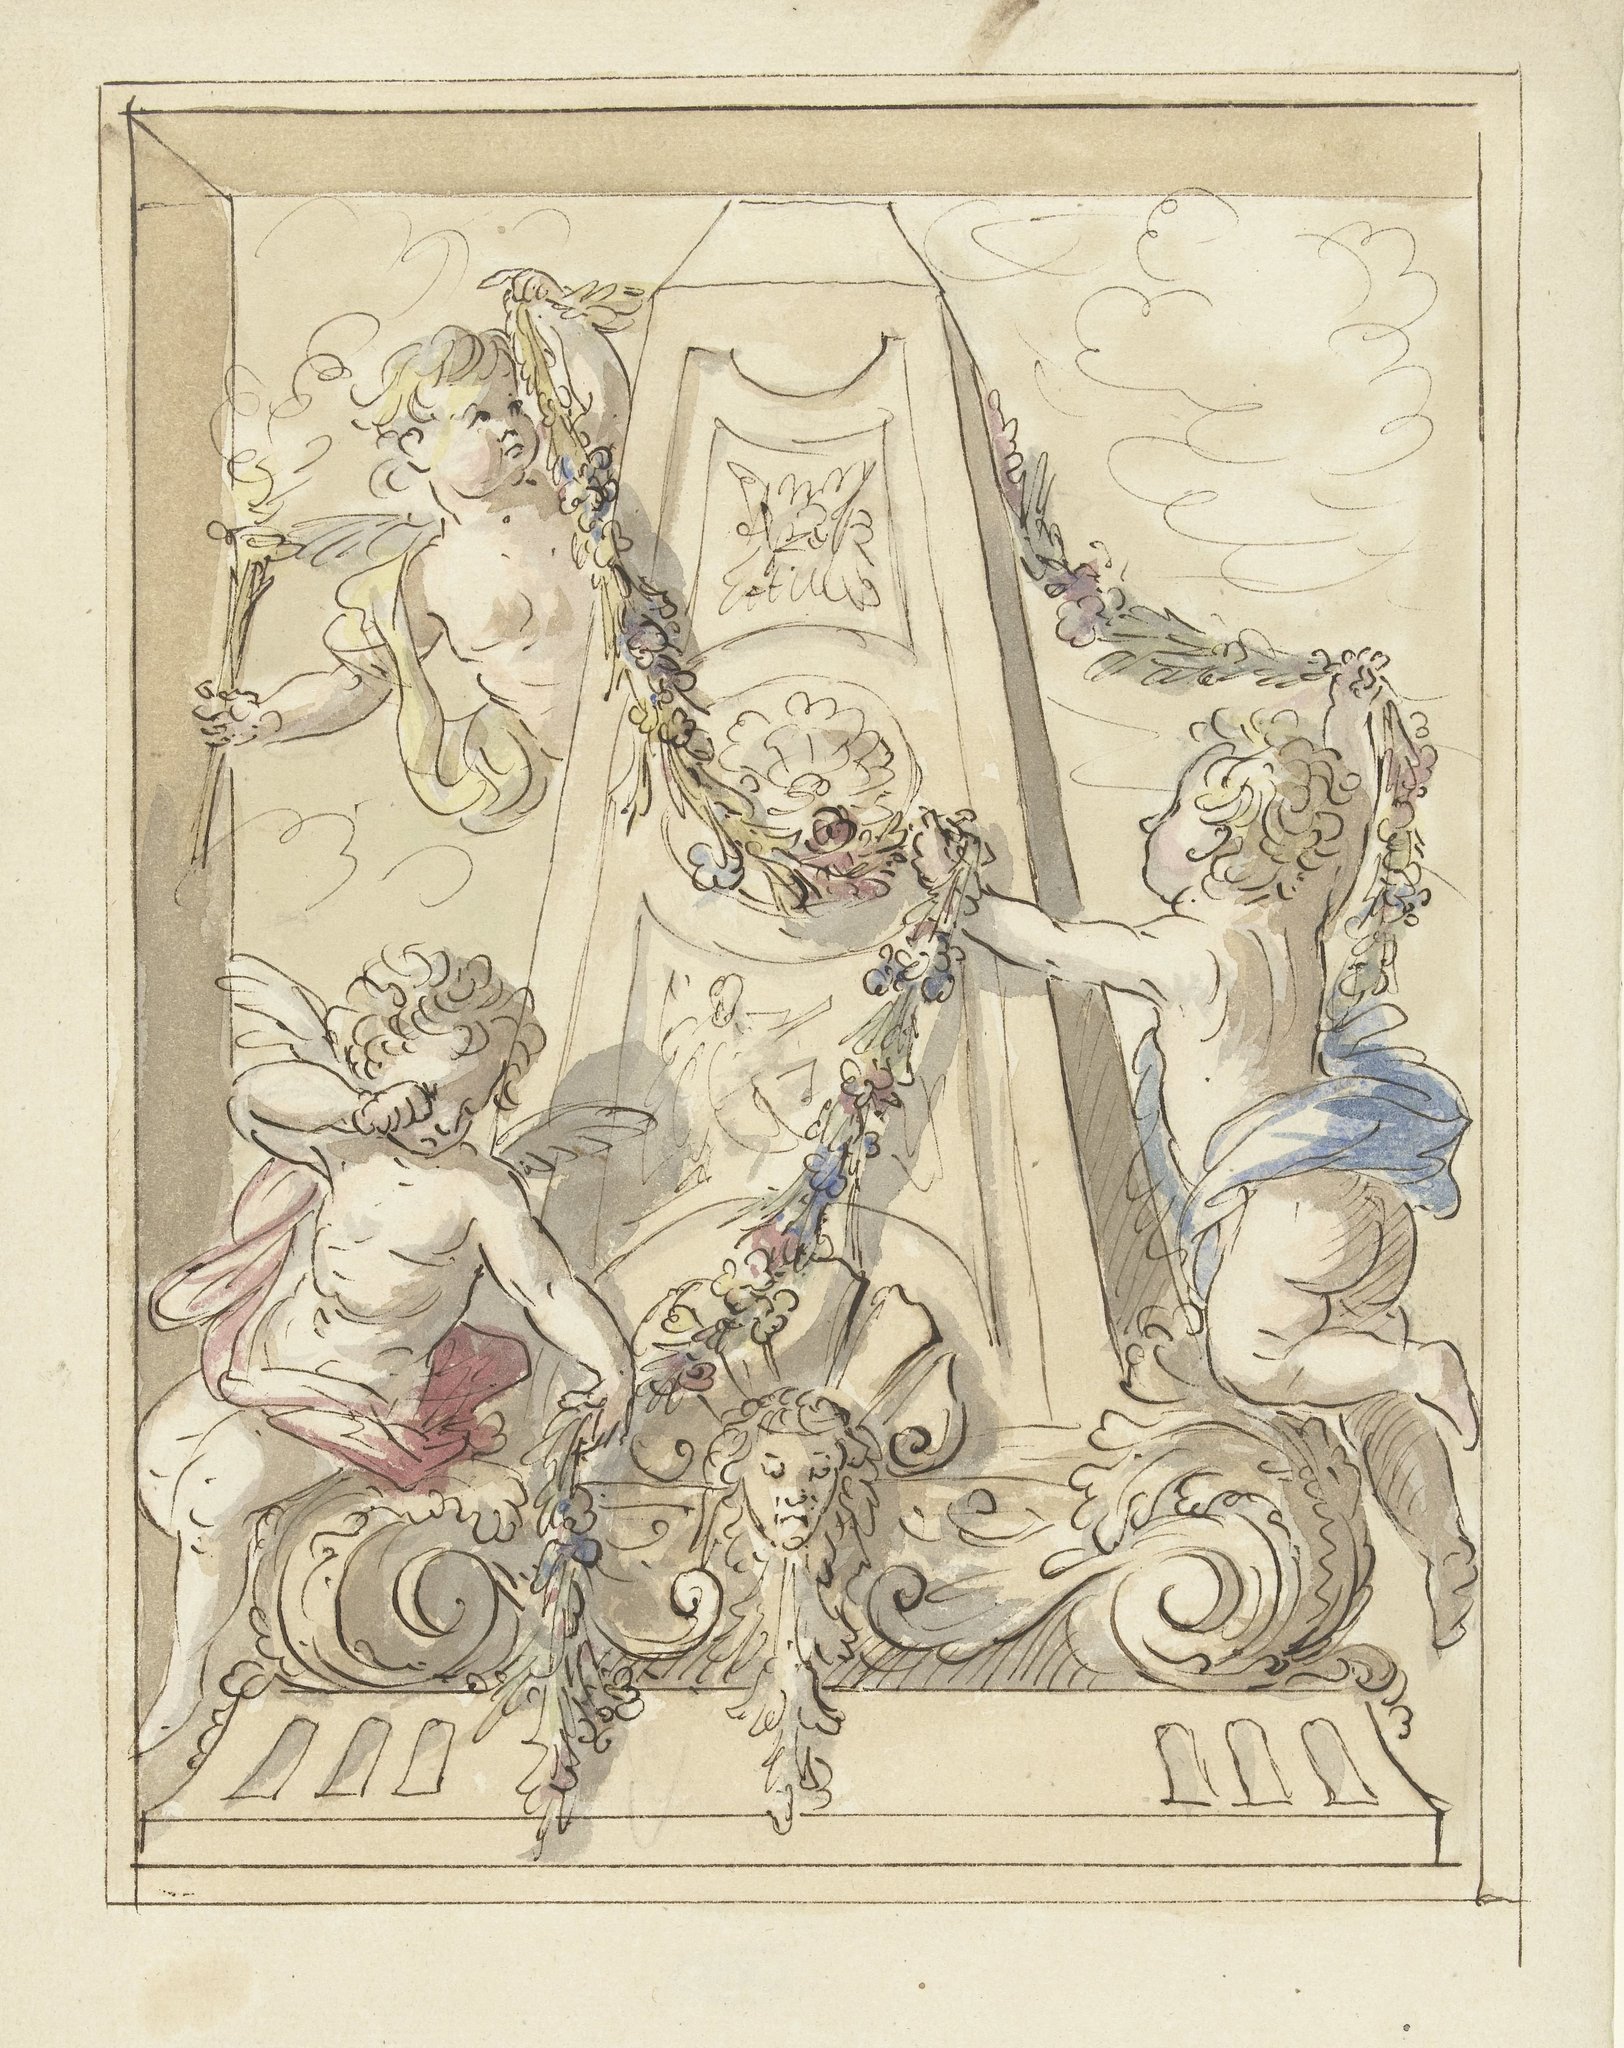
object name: design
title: Monument door treurende putti met slingers behangen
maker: elias van nijmegen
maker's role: draughtsman, painter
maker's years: 1667-1755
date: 1677-1755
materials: ink, paper, pencil, watercolor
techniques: brush, pen